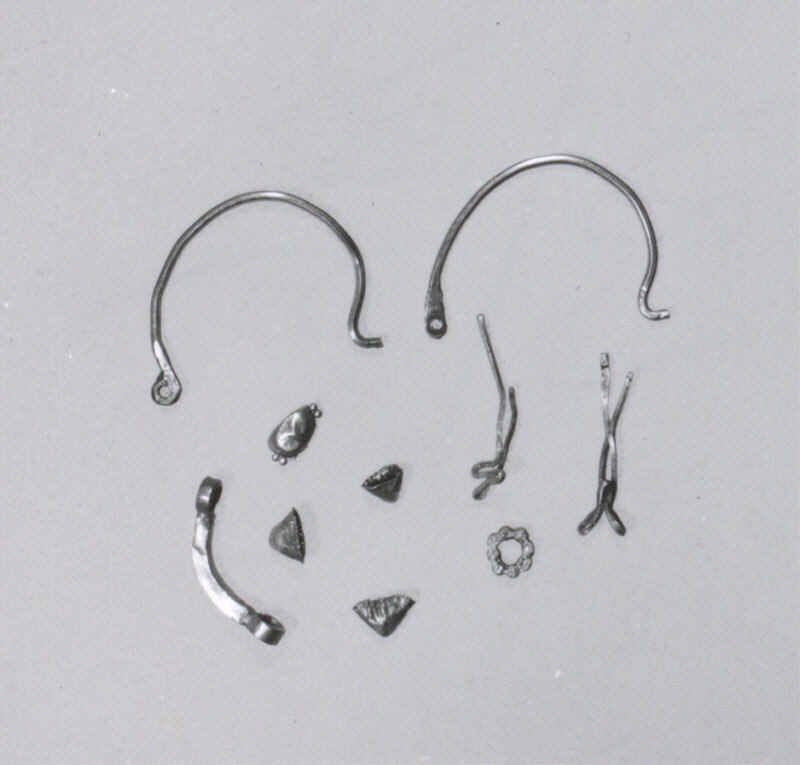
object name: jewellery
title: Jewelry fragments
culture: iranian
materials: gold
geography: iran